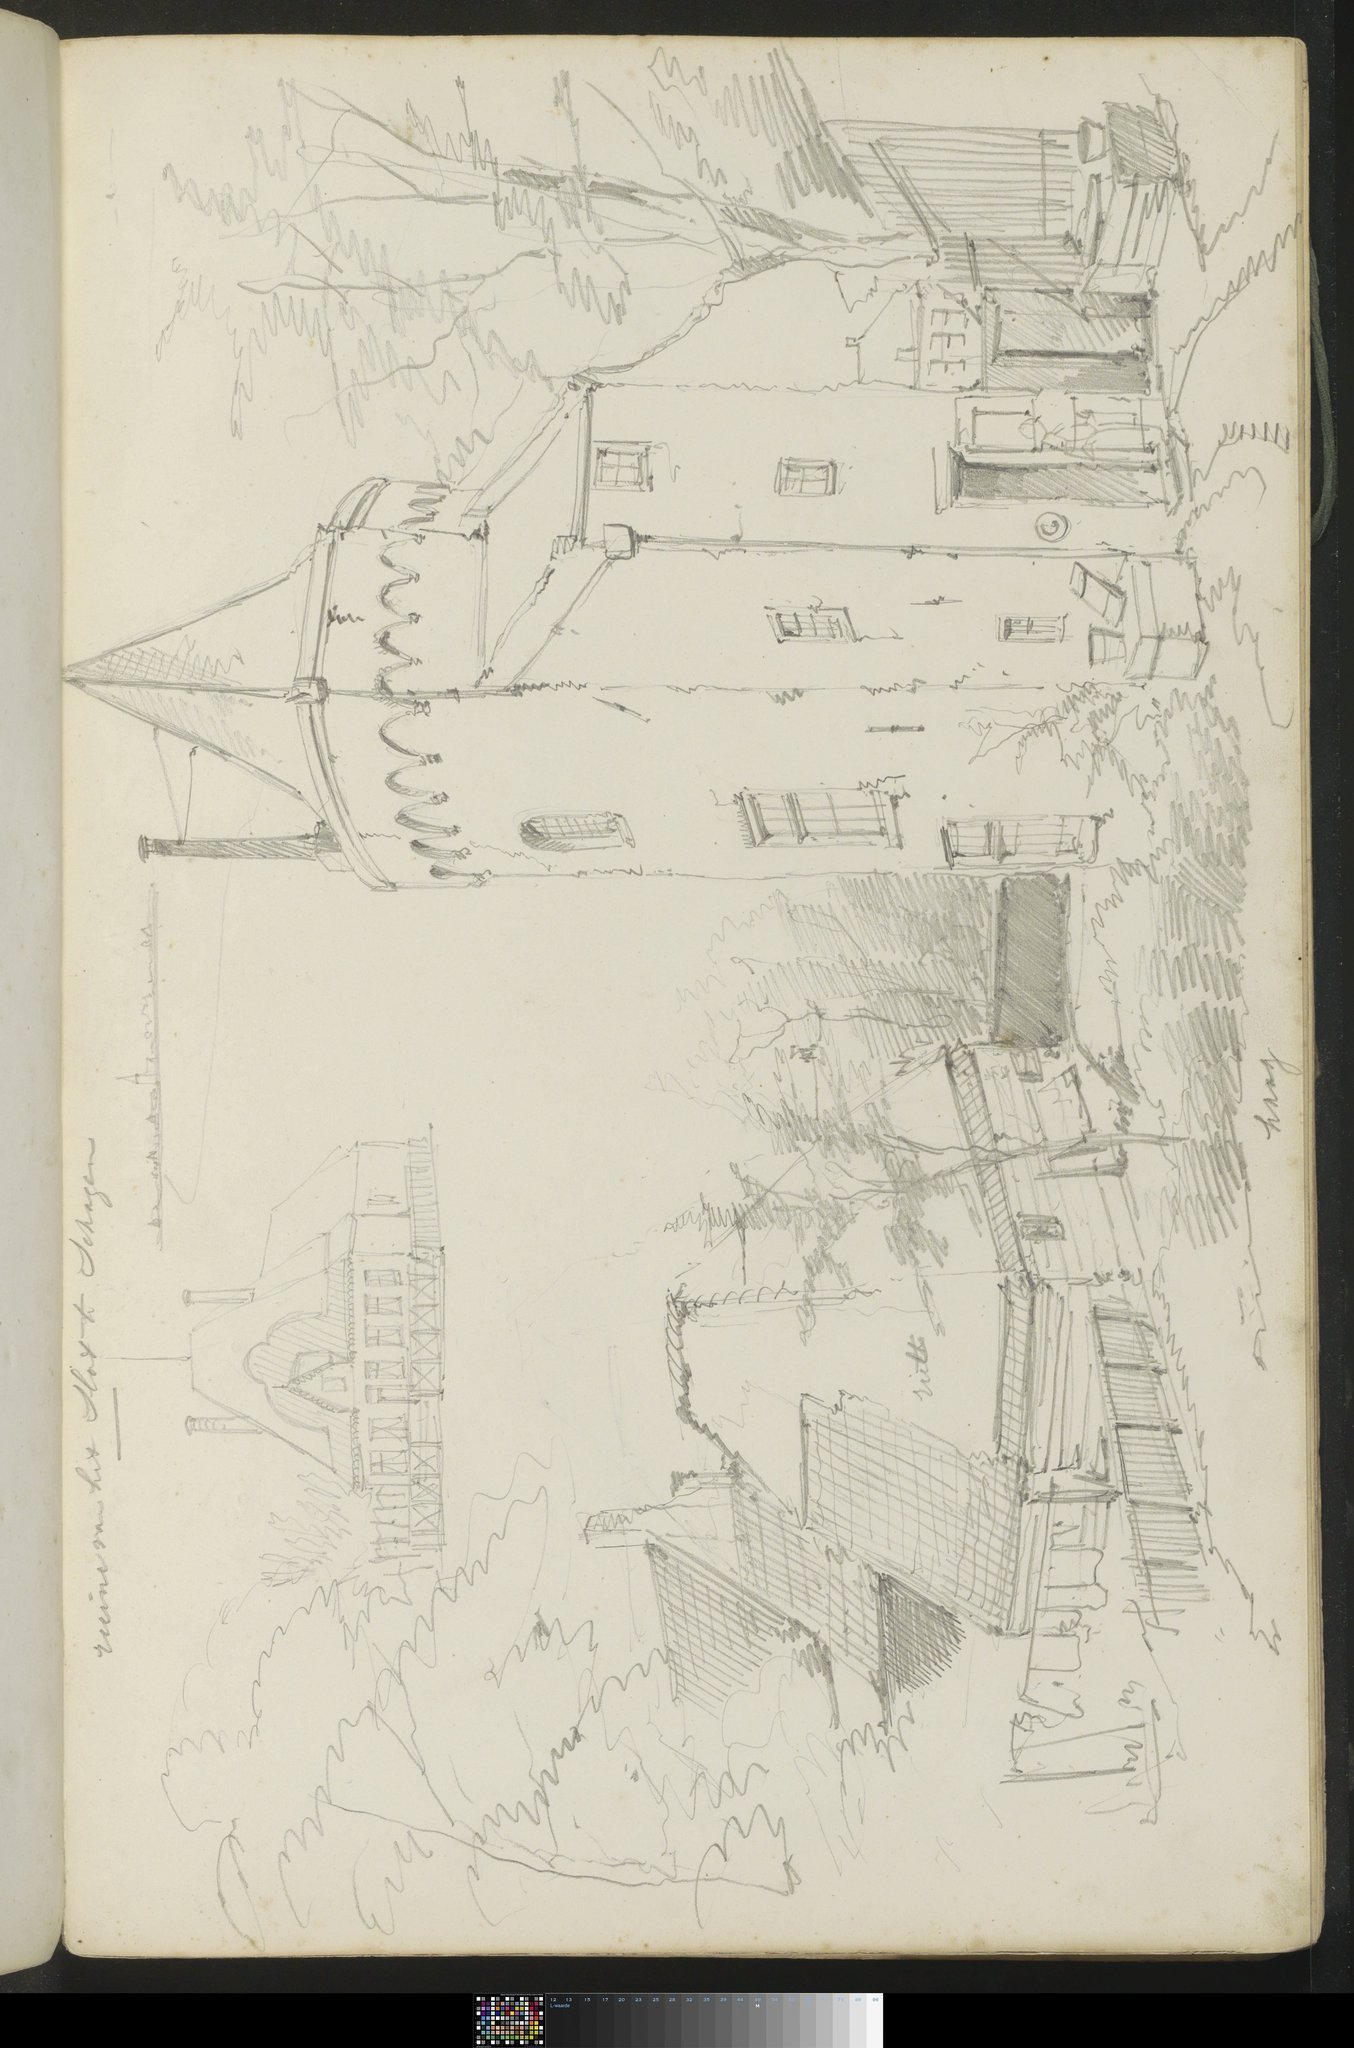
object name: sketchbook leaf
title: Ruïne van het Slot van Schagen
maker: willem koekkoek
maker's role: draughtsman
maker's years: 1839-1895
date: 1849-1895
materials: paper, pencil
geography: schagen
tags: ruin of a dwelling, house, castle, etc.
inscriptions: annotation: ‘ruine van het Slot te Schagen/ riet/ haag’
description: Blad 13 recto uit een schetsboek met 35 bladen.